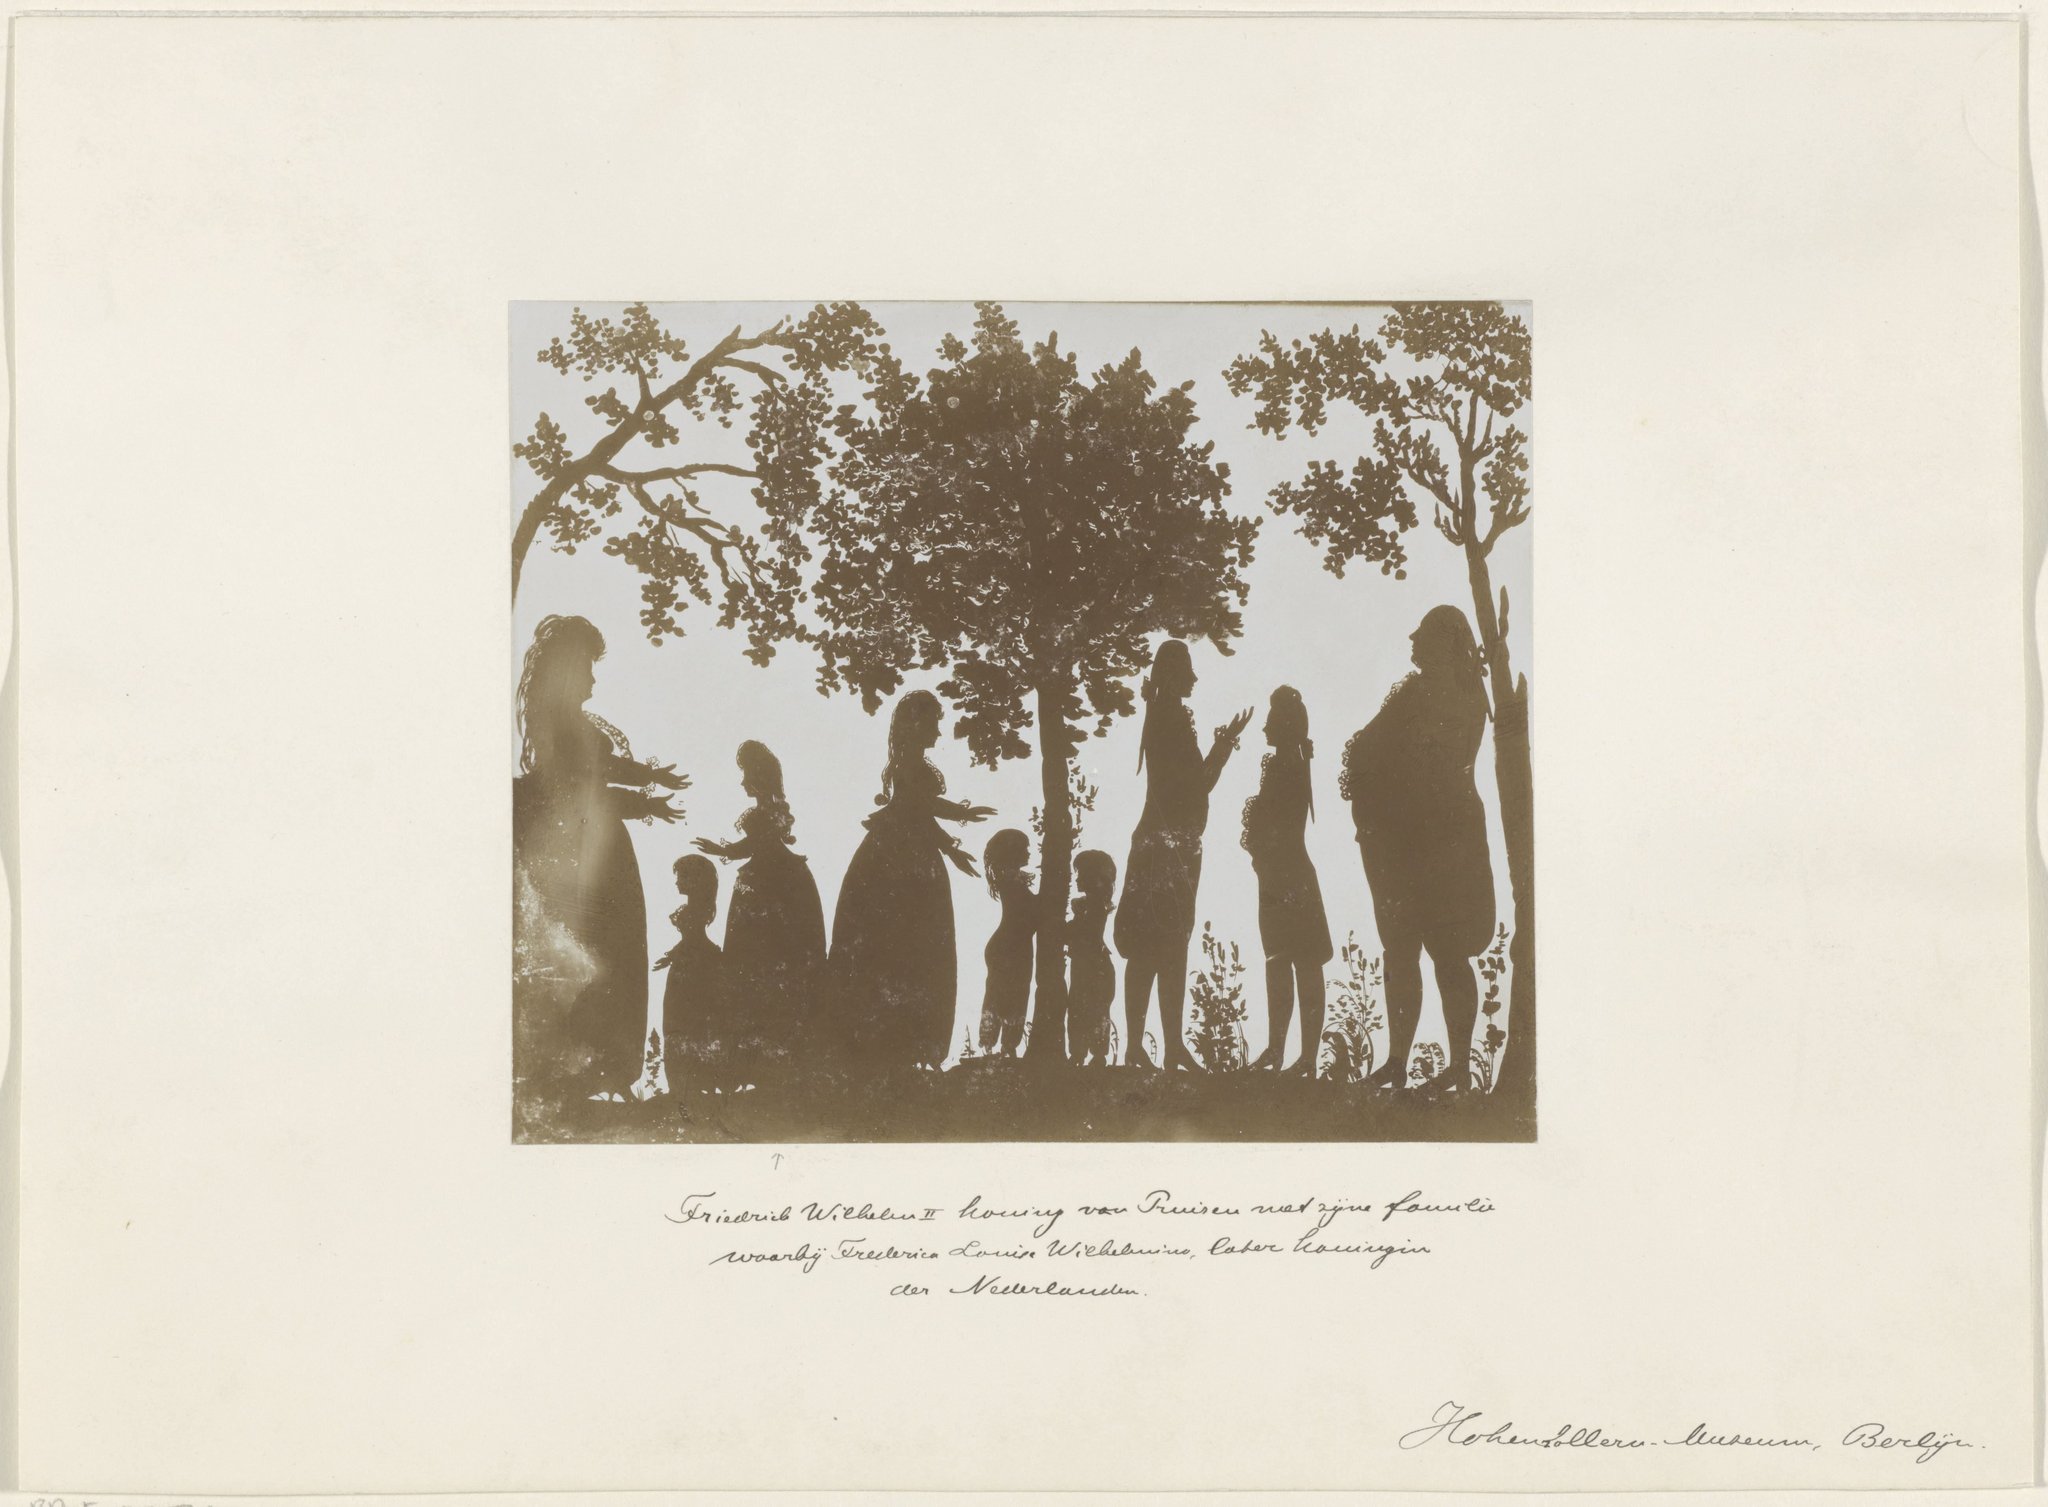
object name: photograph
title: Silhouetportret van Frederik Willem II, koning van Pruisen, Wilhelmina van Pruisen en hun familie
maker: Anonymous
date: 1850-1930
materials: photographic support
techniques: photography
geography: netherlands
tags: berlin, frederik willem ii (koning van pruisen), wilhelmina frederica louisa (koningin der nederlanden)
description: De hier vermelde titel verwijst naar de hoogst verkregen titel van de geportretteerde, niet per se naar de titel die de geportretteerde op deze voorstelling draagt.